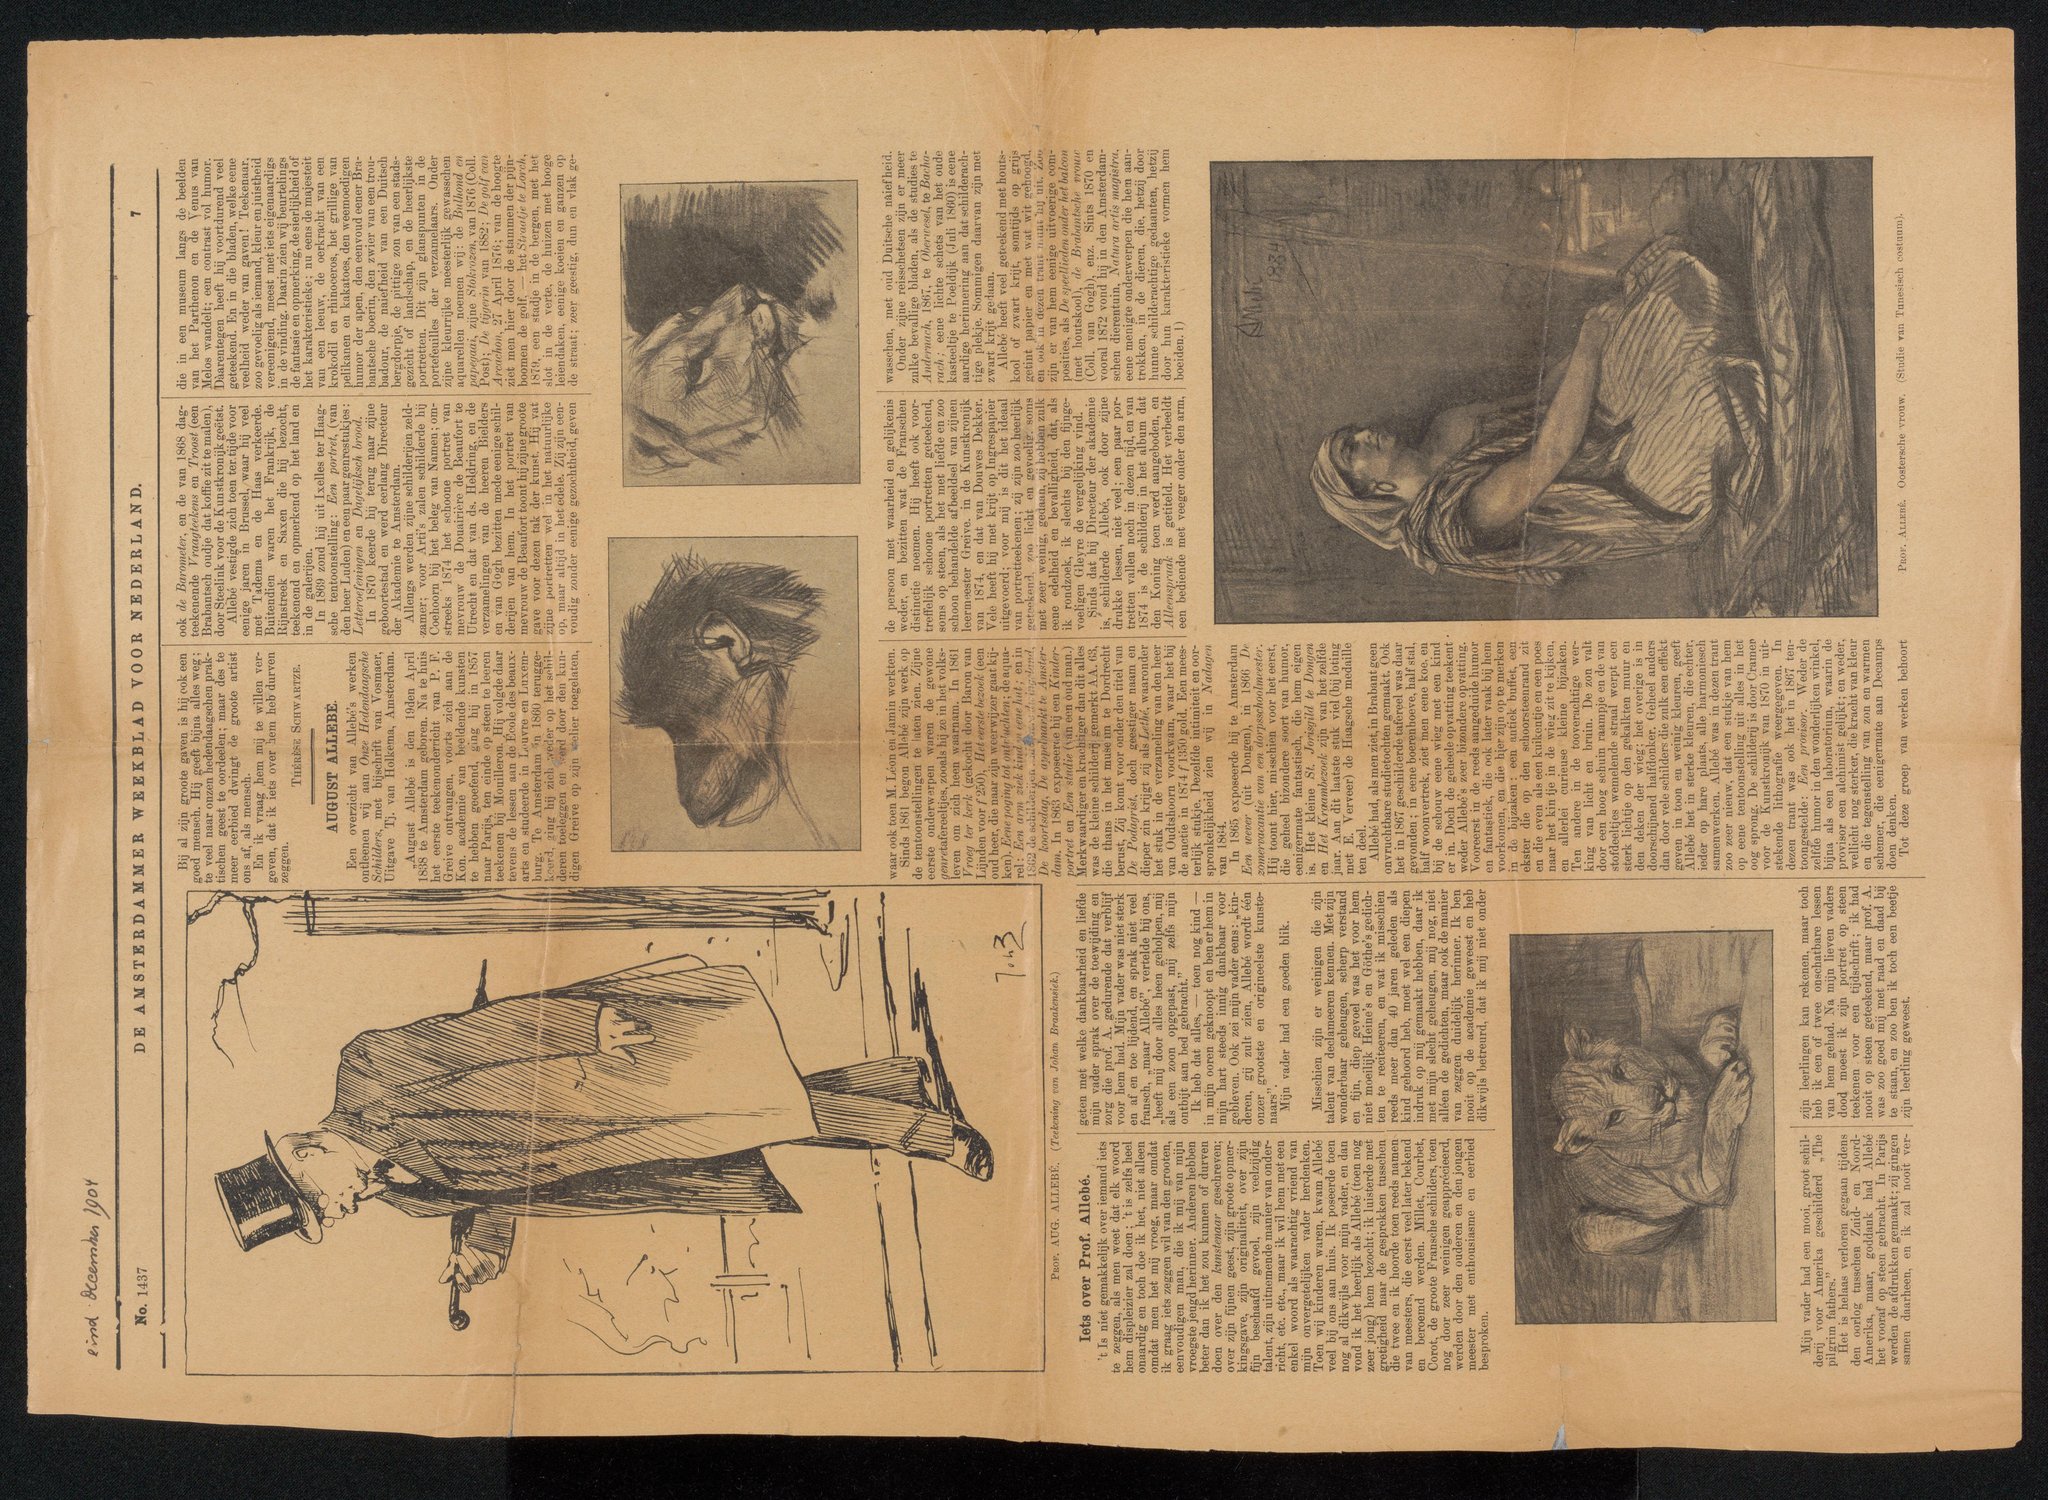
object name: newspaper clipping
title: Krantenknipsel uit archief Jan Veth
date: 1904-1912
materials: paper, ink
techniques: printing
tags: august allebé, amsterdam, painter, print maker, draughtsman, designer, jan veth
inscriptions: collector's mark: ‘RPK’